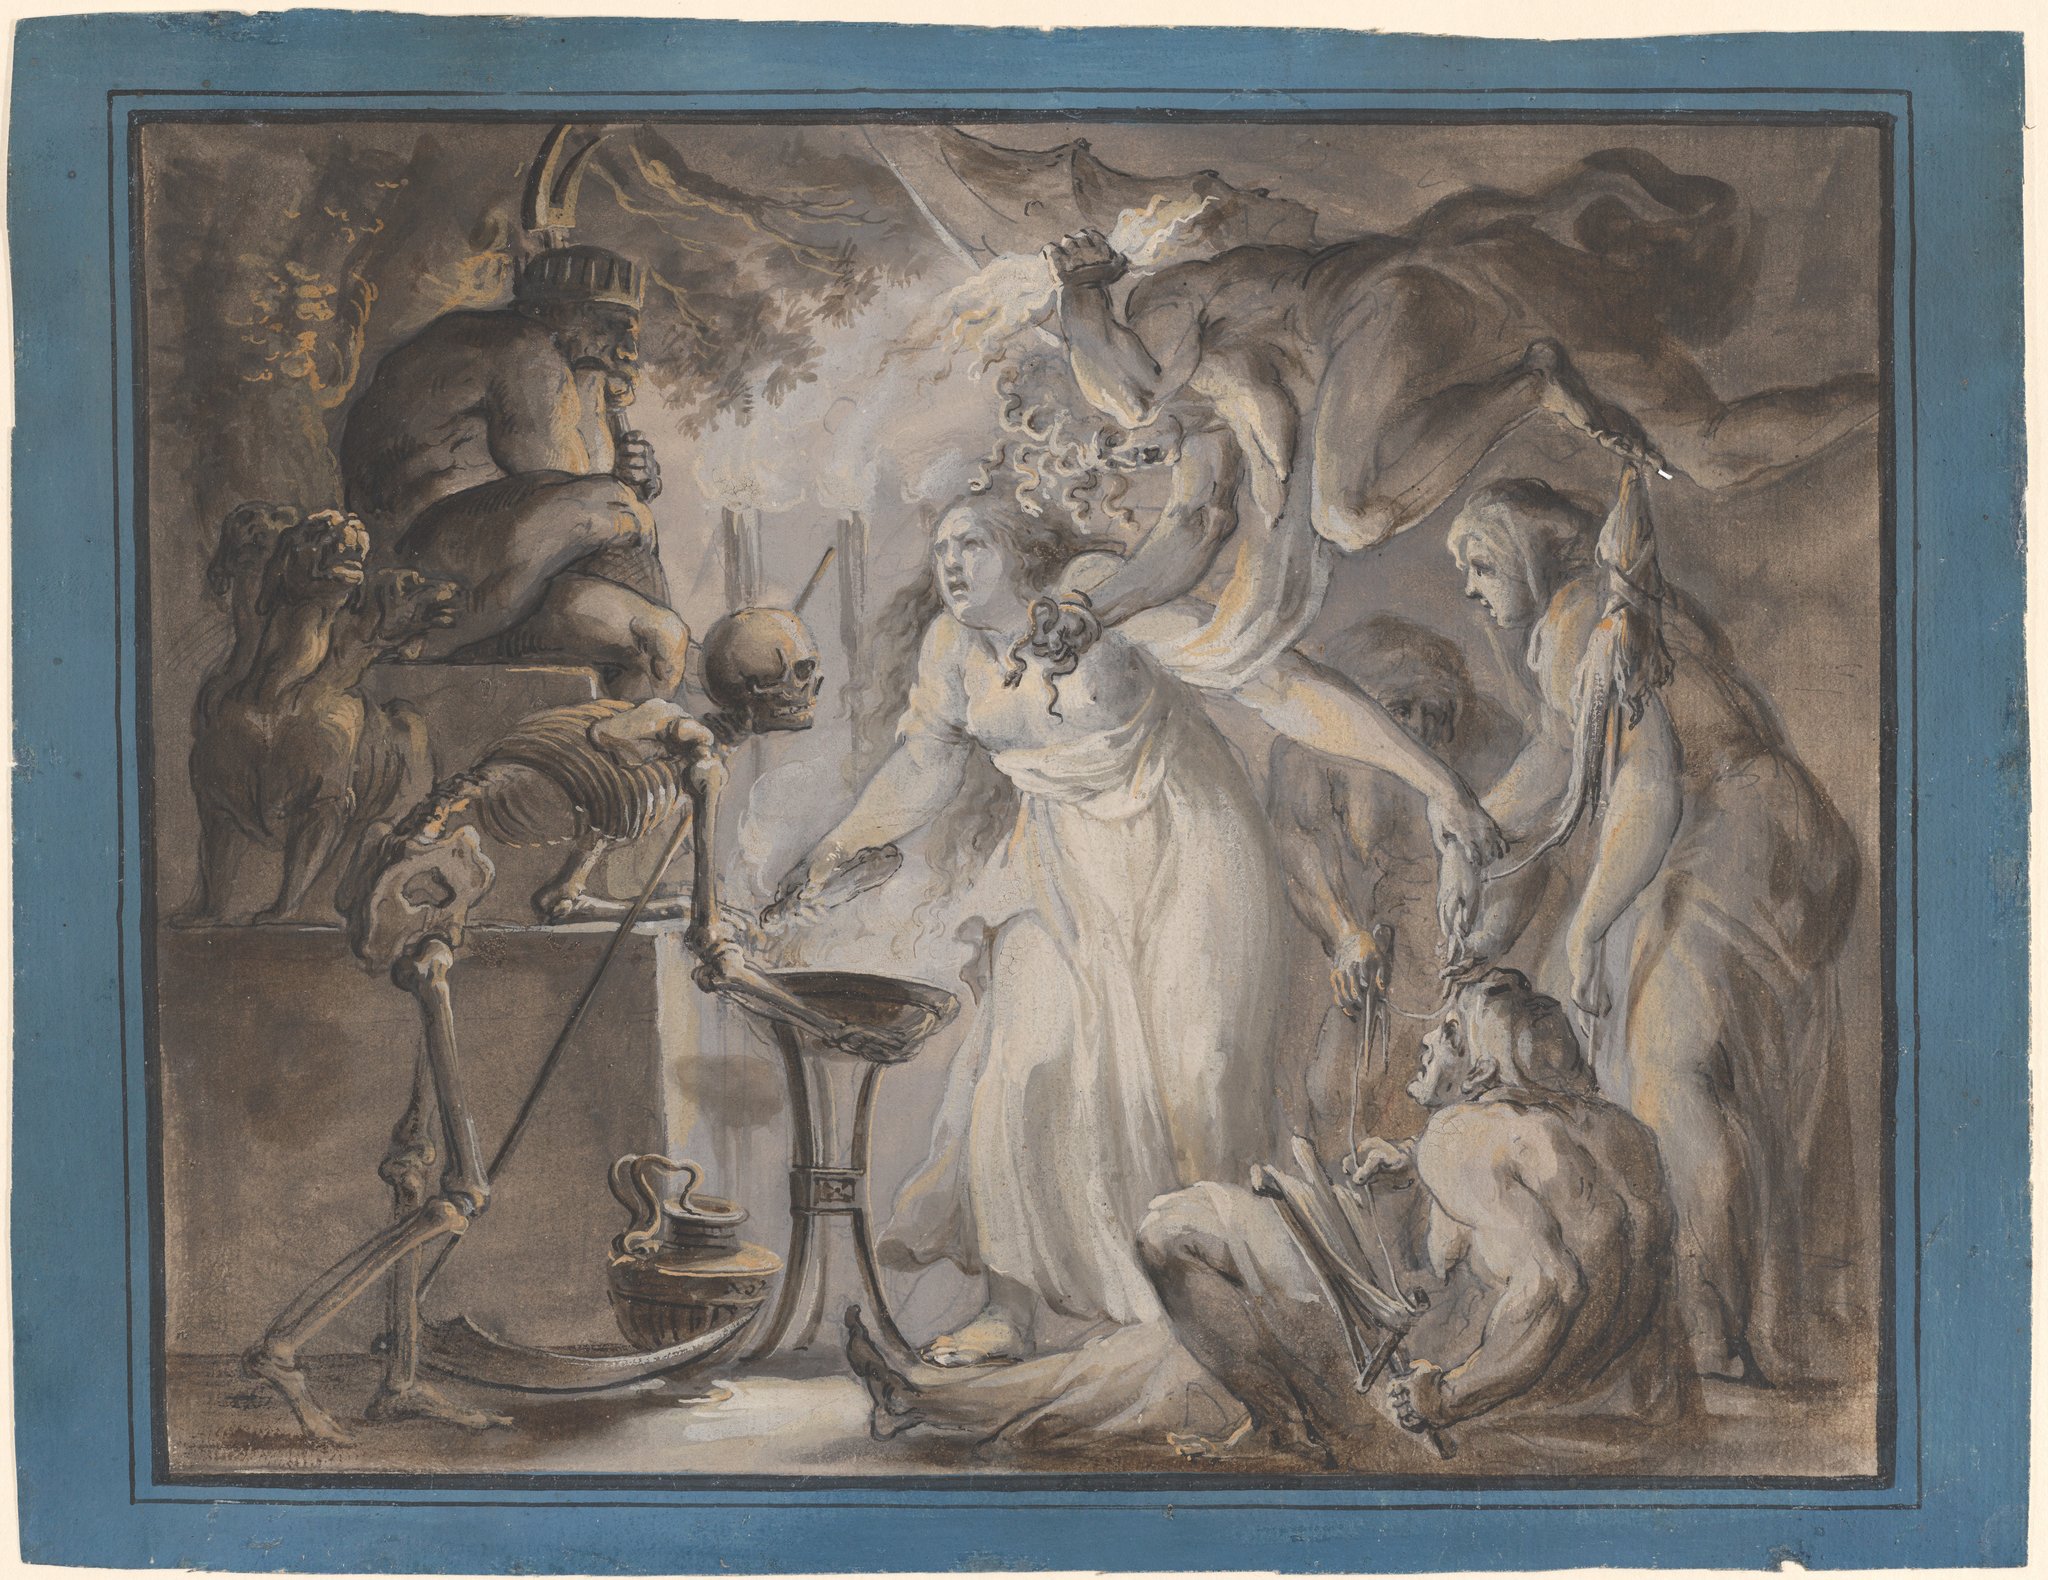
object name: drawing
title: A Nightmare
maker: giovanni david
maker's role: artist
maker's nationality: italian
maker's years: 1749-1790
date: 1775-1780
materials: chalk, ink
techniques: drawing, heightening, pen, wash